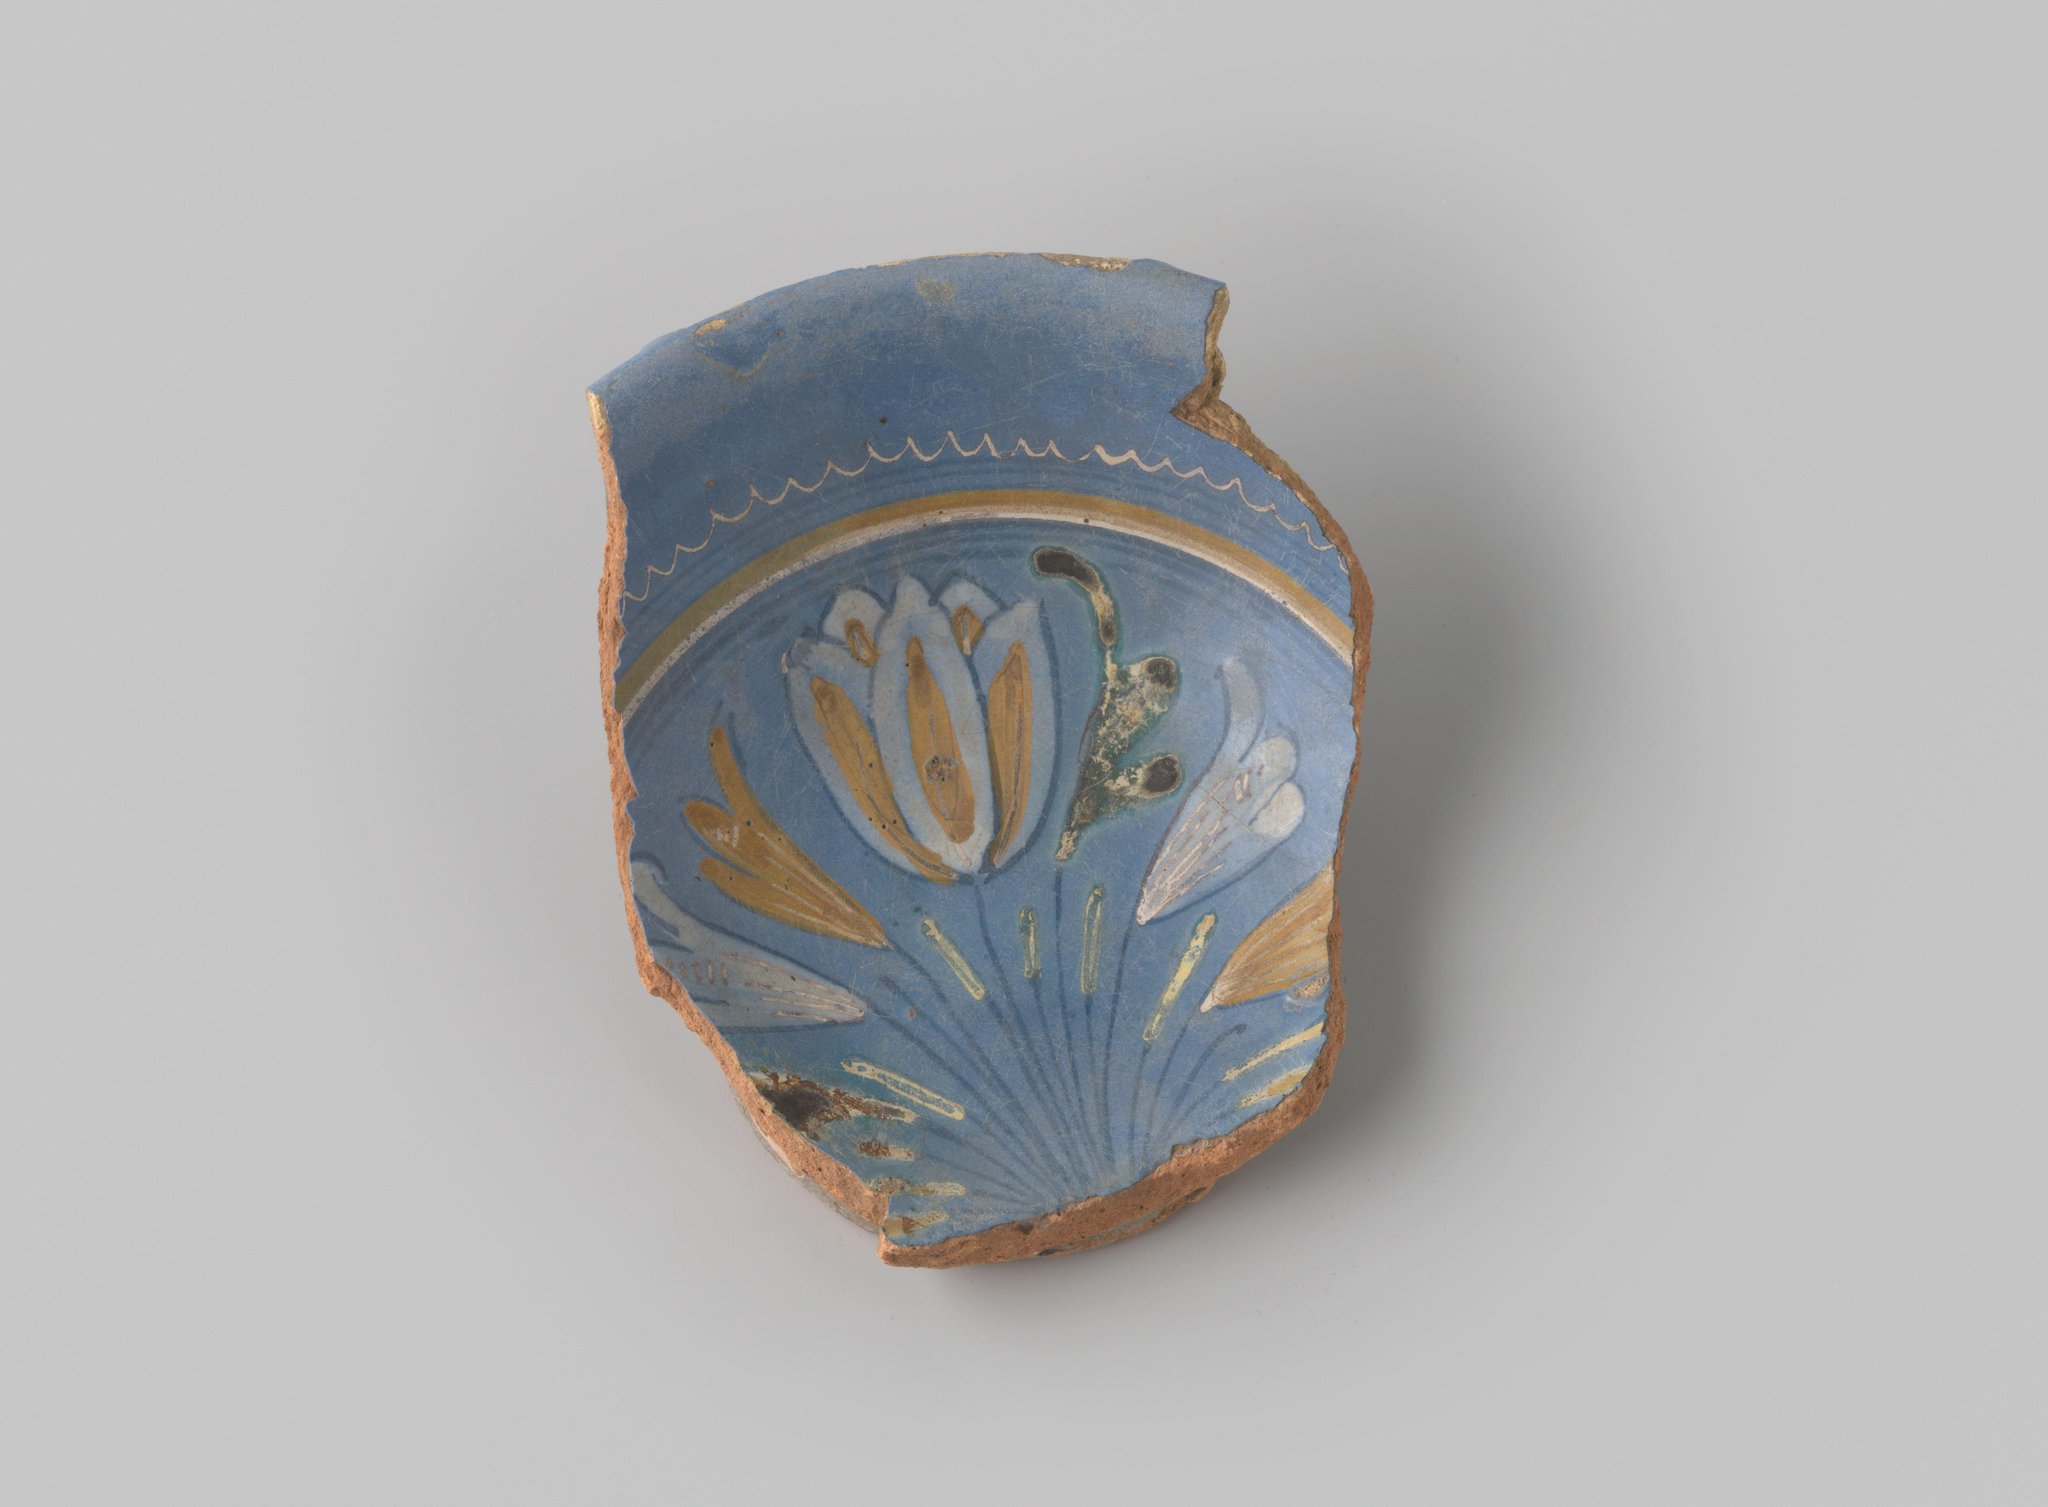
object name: fragment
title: Scherf van roodbakkend aardewerk, met standring, aan de voorzijde voorzien van blauw glazuur, waarop een bos bloemen in geel, wit, blauw, groen en oranje, er omheen strepen en een gegolfde rand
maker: Anonymous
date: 1600-1650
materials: earthenware, glaze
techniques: maiolica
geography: northern netherlands